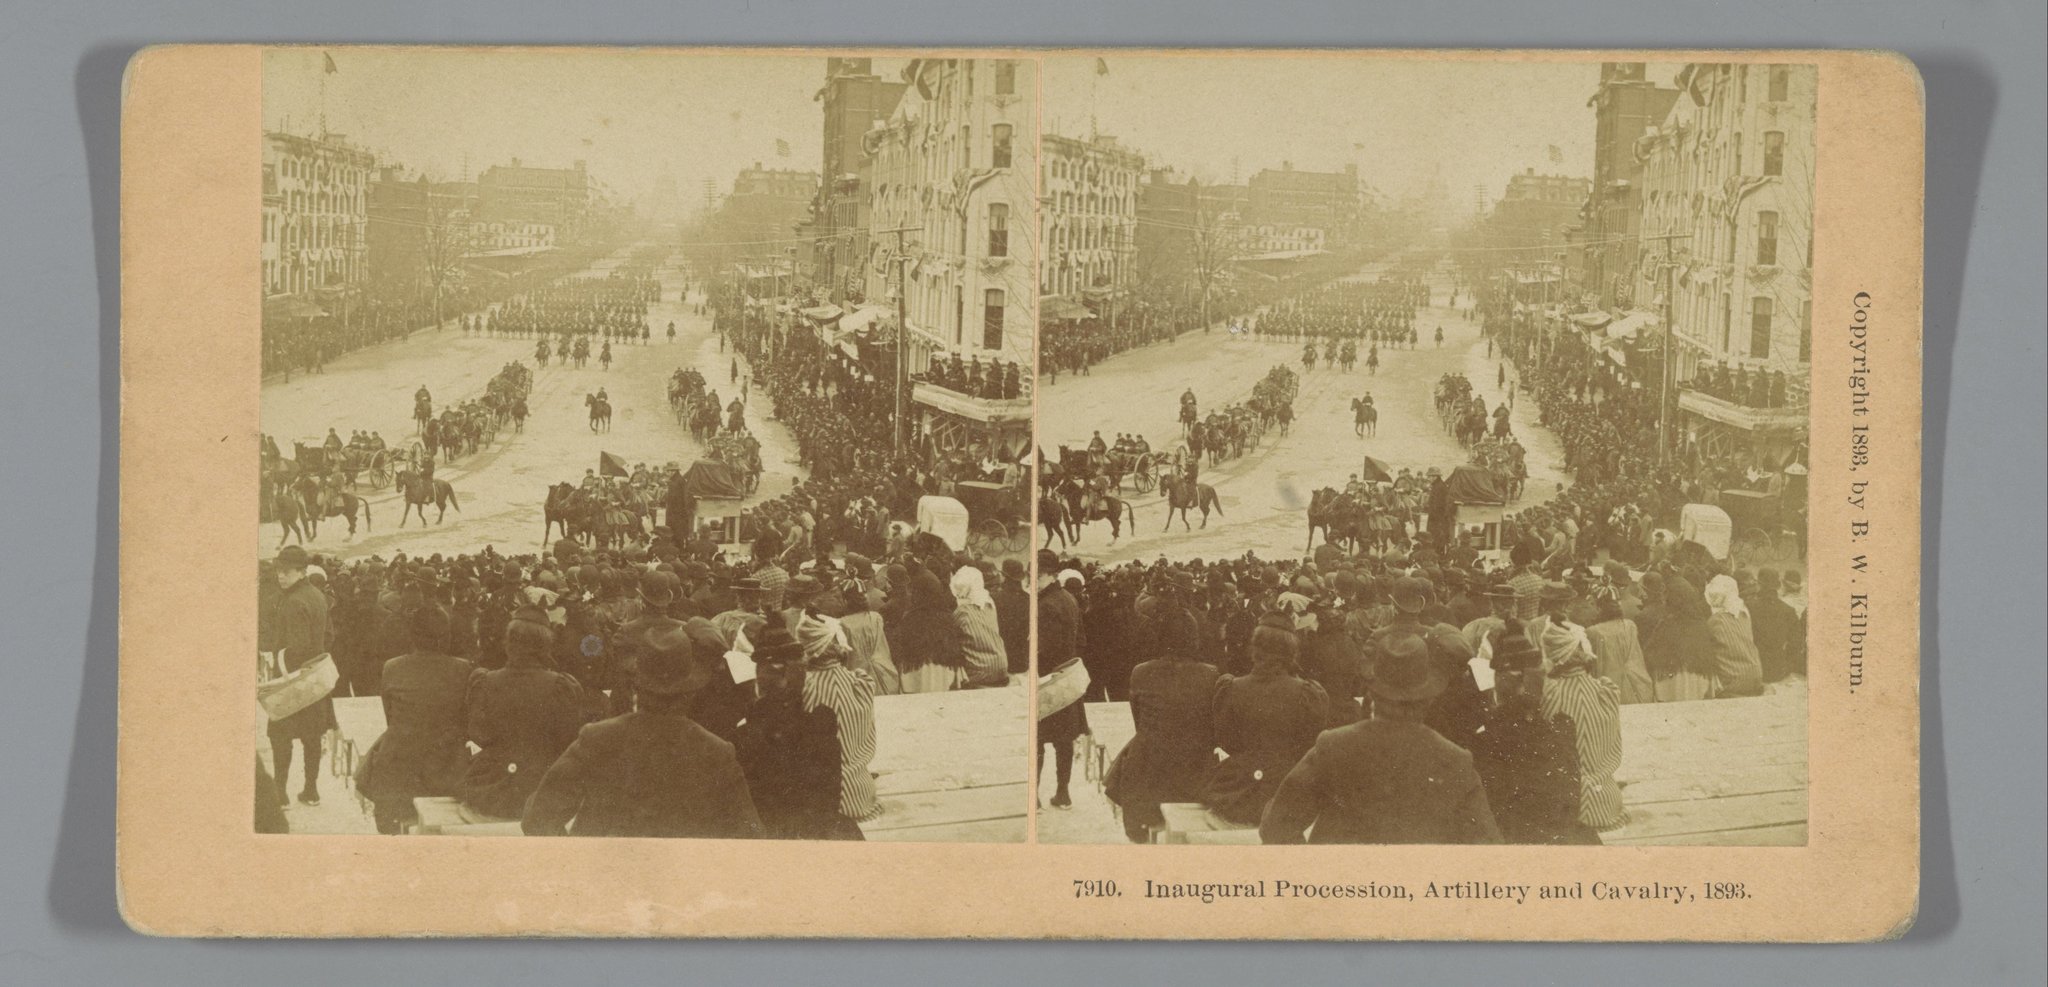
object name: stereograph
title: Inauguratie van de tweede termijn van President Grover Cleveland, Washington D.C.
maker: benjamin west kilburn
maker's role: fotograaf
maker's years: 1827-1909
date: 1893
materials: cardboard, paper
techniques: albumen print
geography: littleton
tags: coronation procession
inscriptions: copyright notice: ‘Copyright 1893, by B. W. Kilburn.’, number: ‘7910’